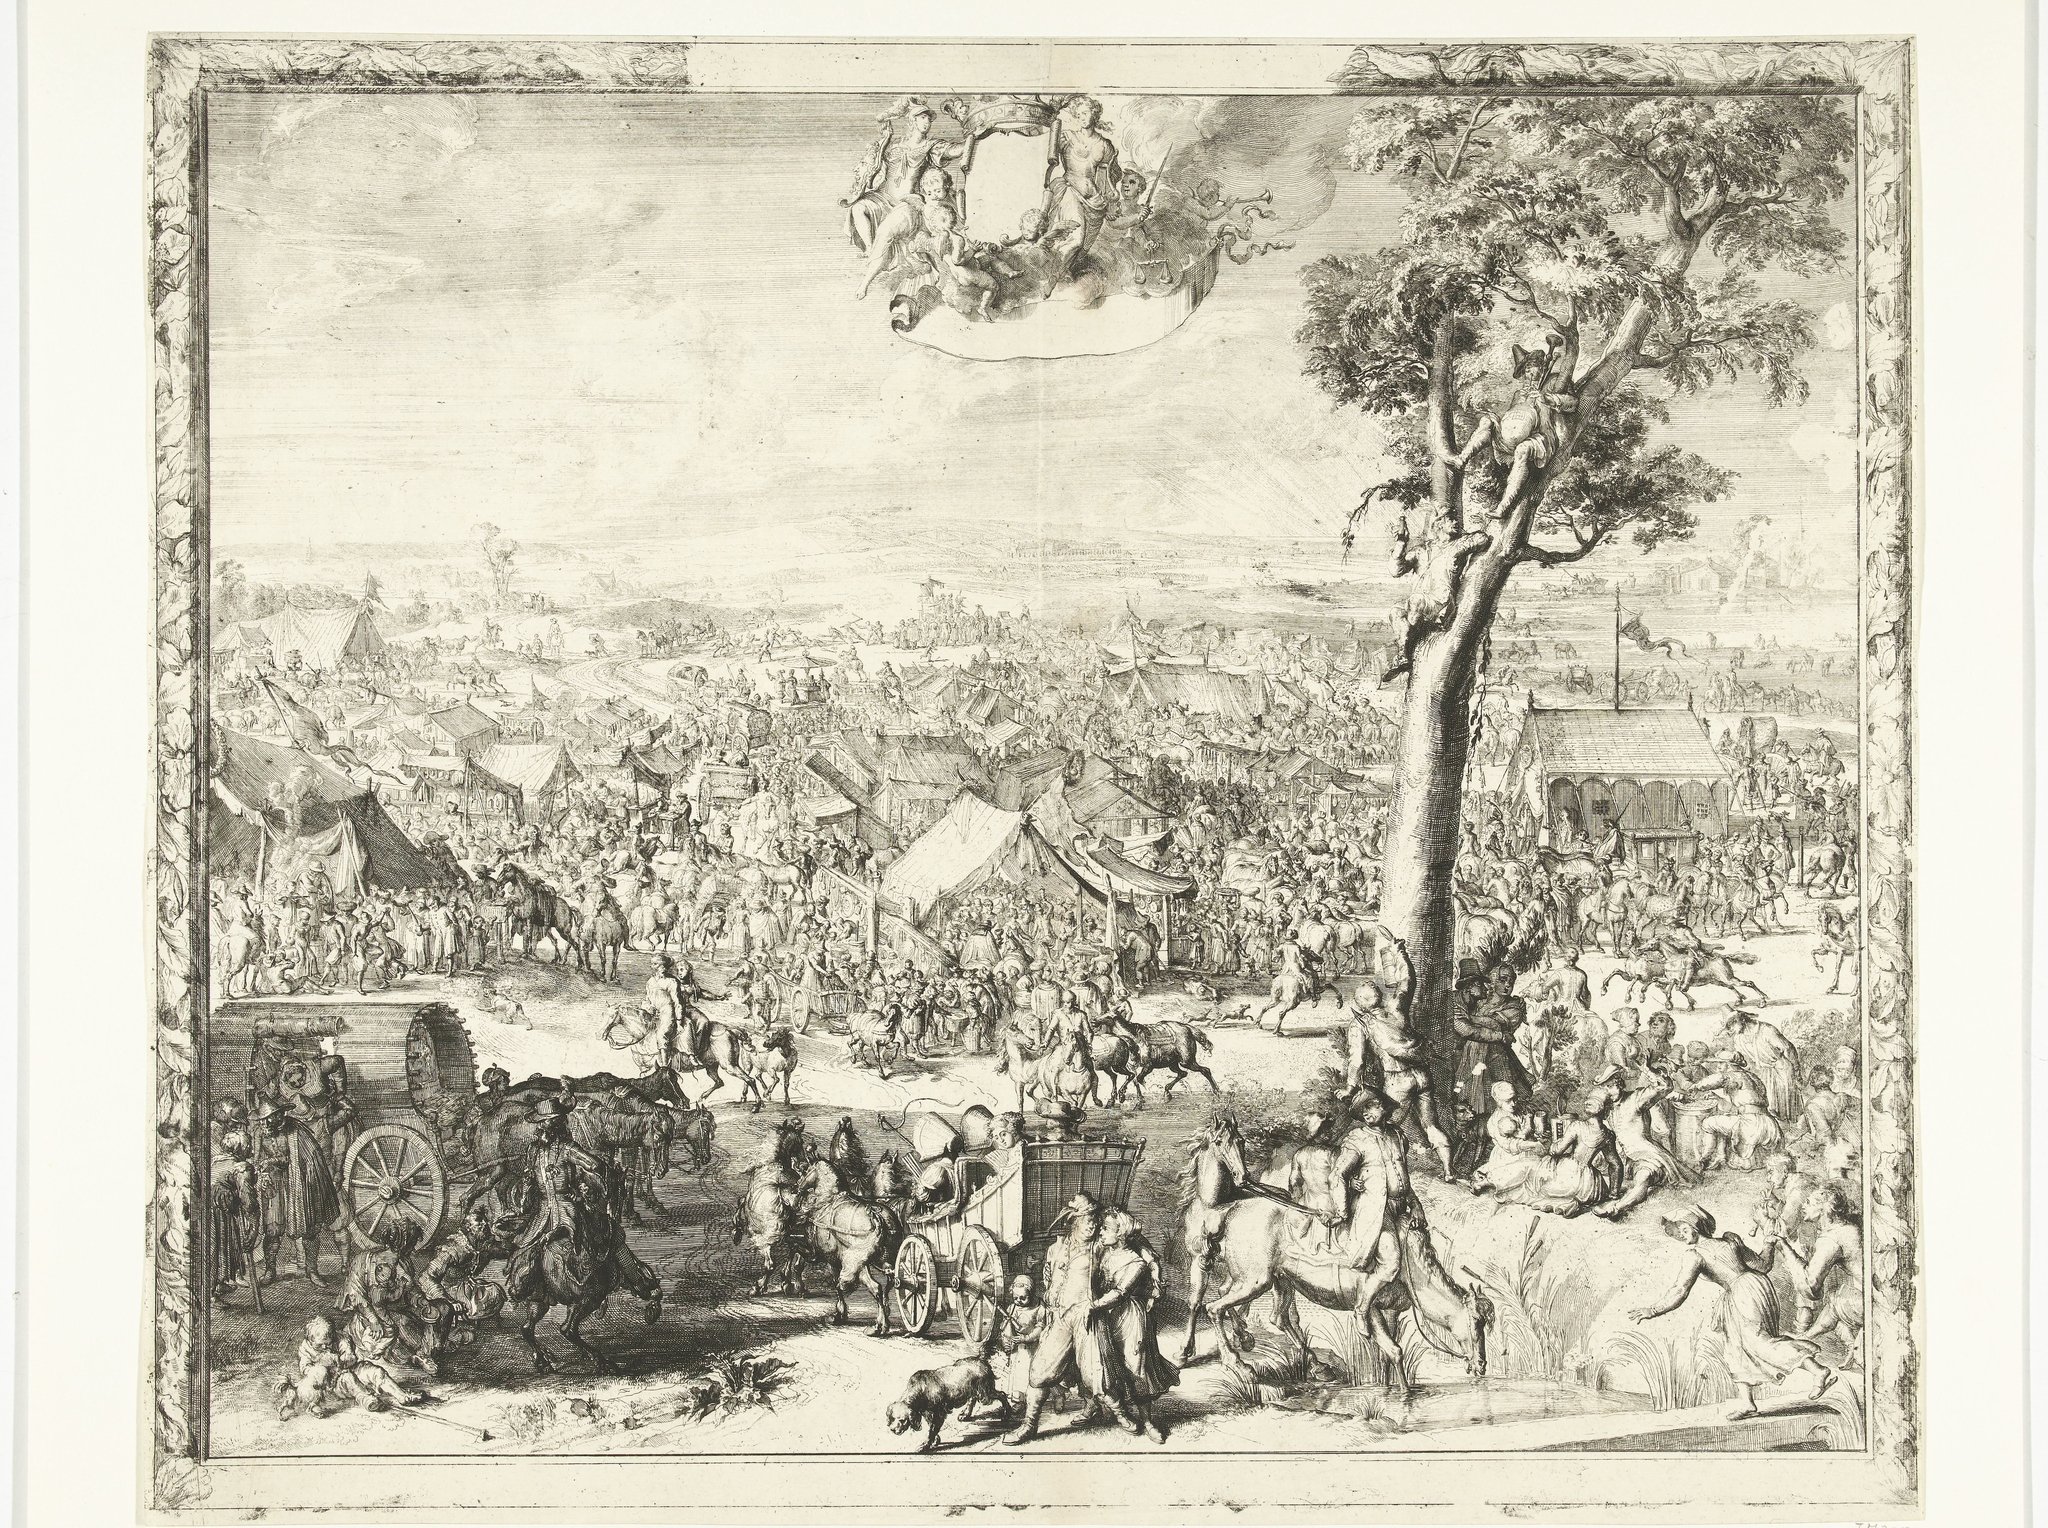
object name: print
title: Jaarmarkt te Arnhem, ca. 1700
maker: romeyn de hooghe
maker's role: draughtsman, goldsmith, painter, print maker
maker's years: 1645-1708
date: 1698-1702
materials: paper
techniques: etching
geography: northern netherlands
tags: (annual) fair, trade fair, arnhem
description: Grote uitvoerige voorstelling van een paardenmarkt en jaarmarkt met kermis gehouden buiten Arnhem, ca. 1700. Vele kramen waarin van alles verkocht wordt en waar gegeten en gedanst wordt. Rechts een boom waarin een doedelzakspeler is geklommen. Bovenaan een oningevulde cartouche. Op de voorgrond laat een ruiter zijn paard drinken.